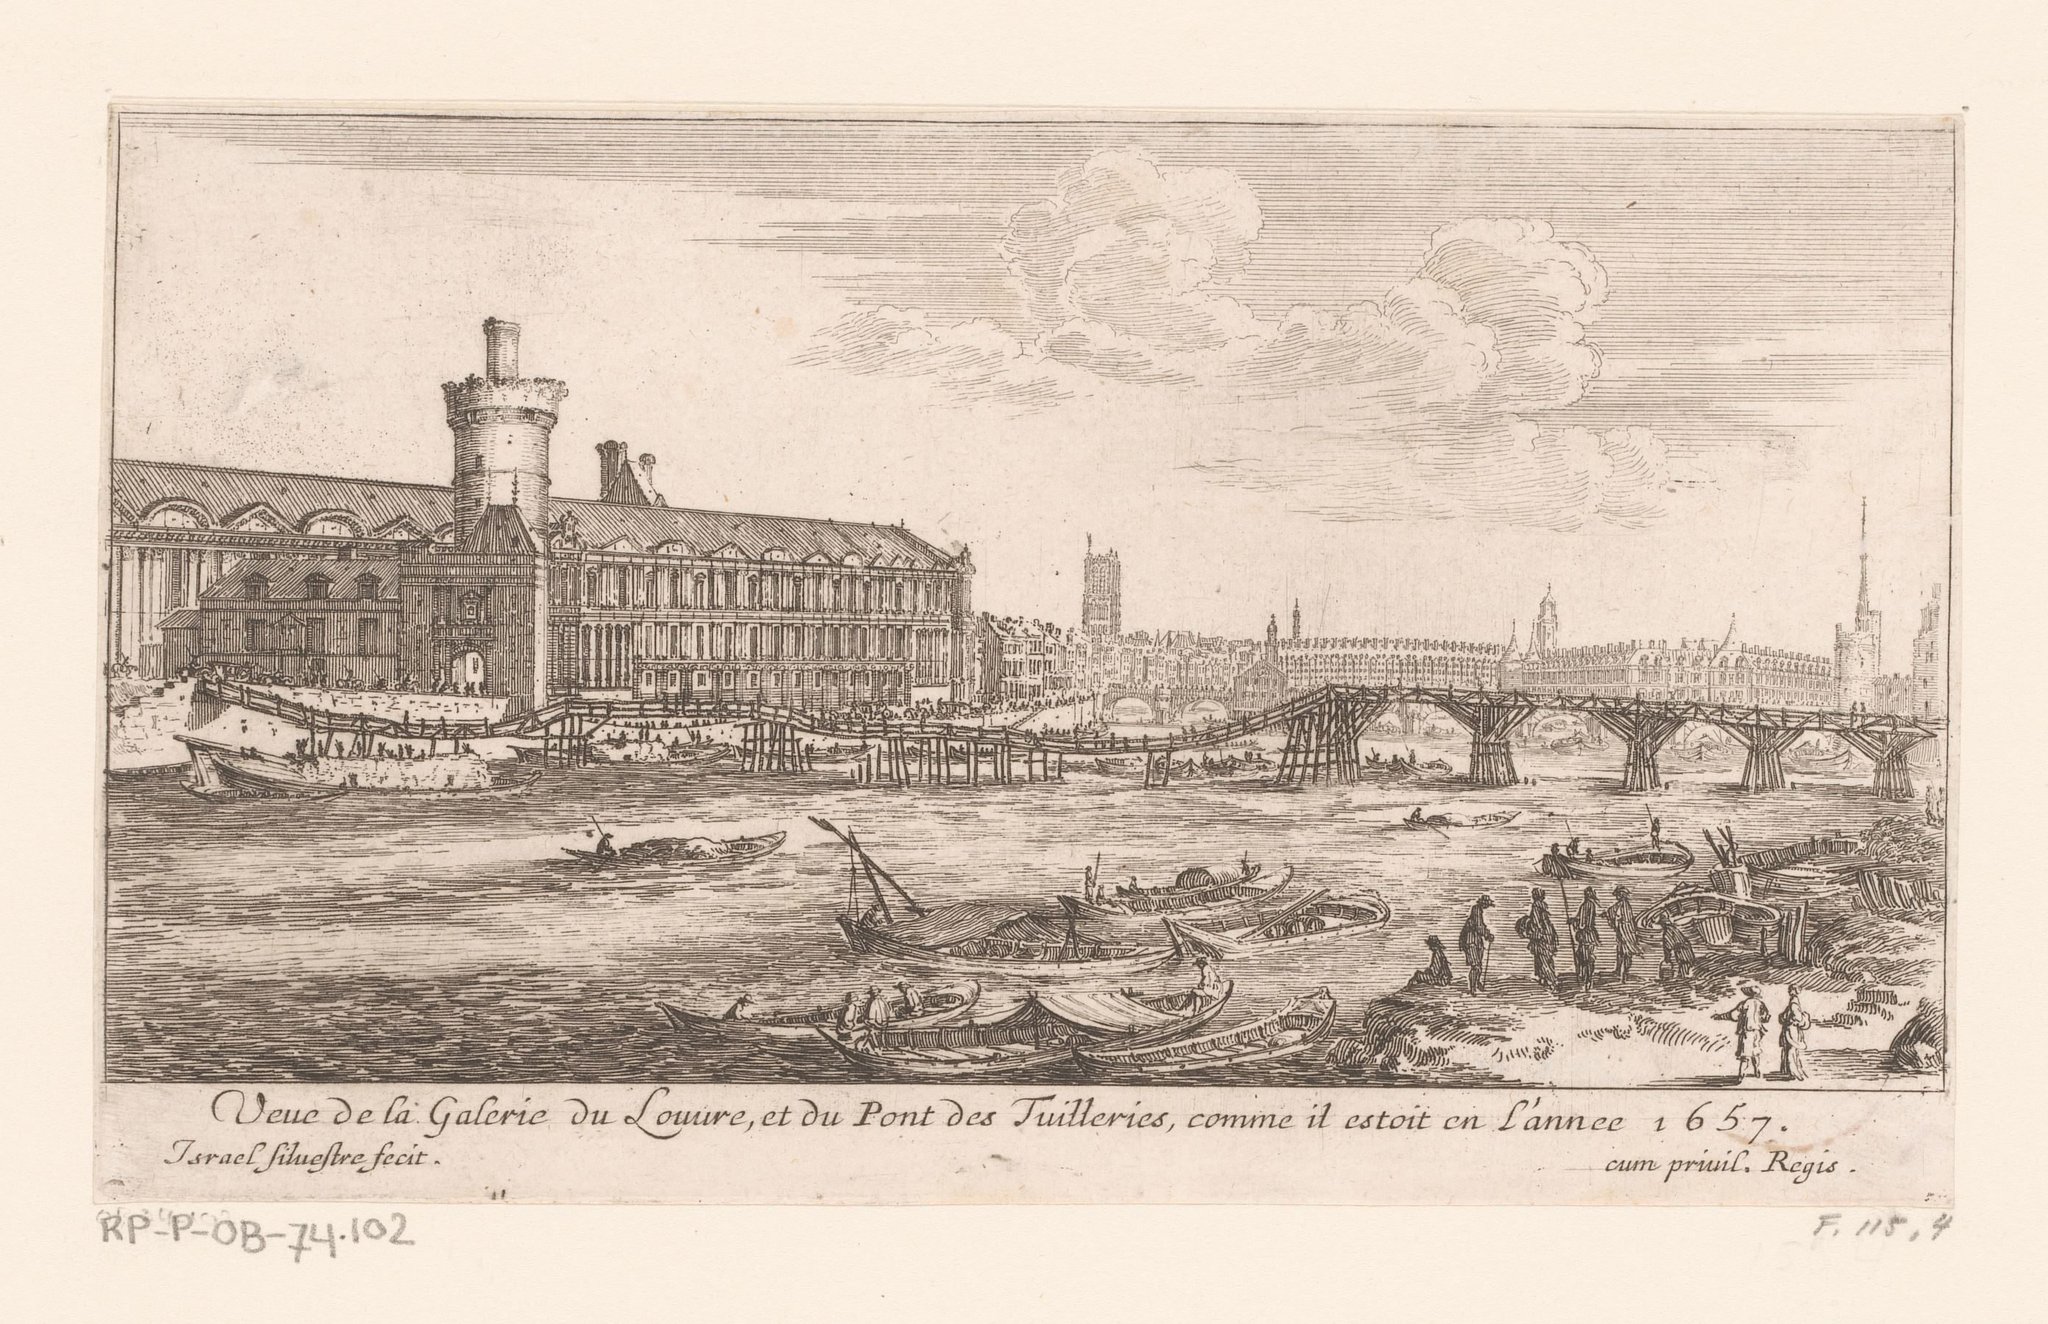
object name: print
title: Gezicht op het Louvre en de Pont des Tuilleries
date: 1657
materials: paper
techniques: etching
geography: france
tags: city-view in general; 'veduta'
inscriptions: collector's mark: Lugt 240